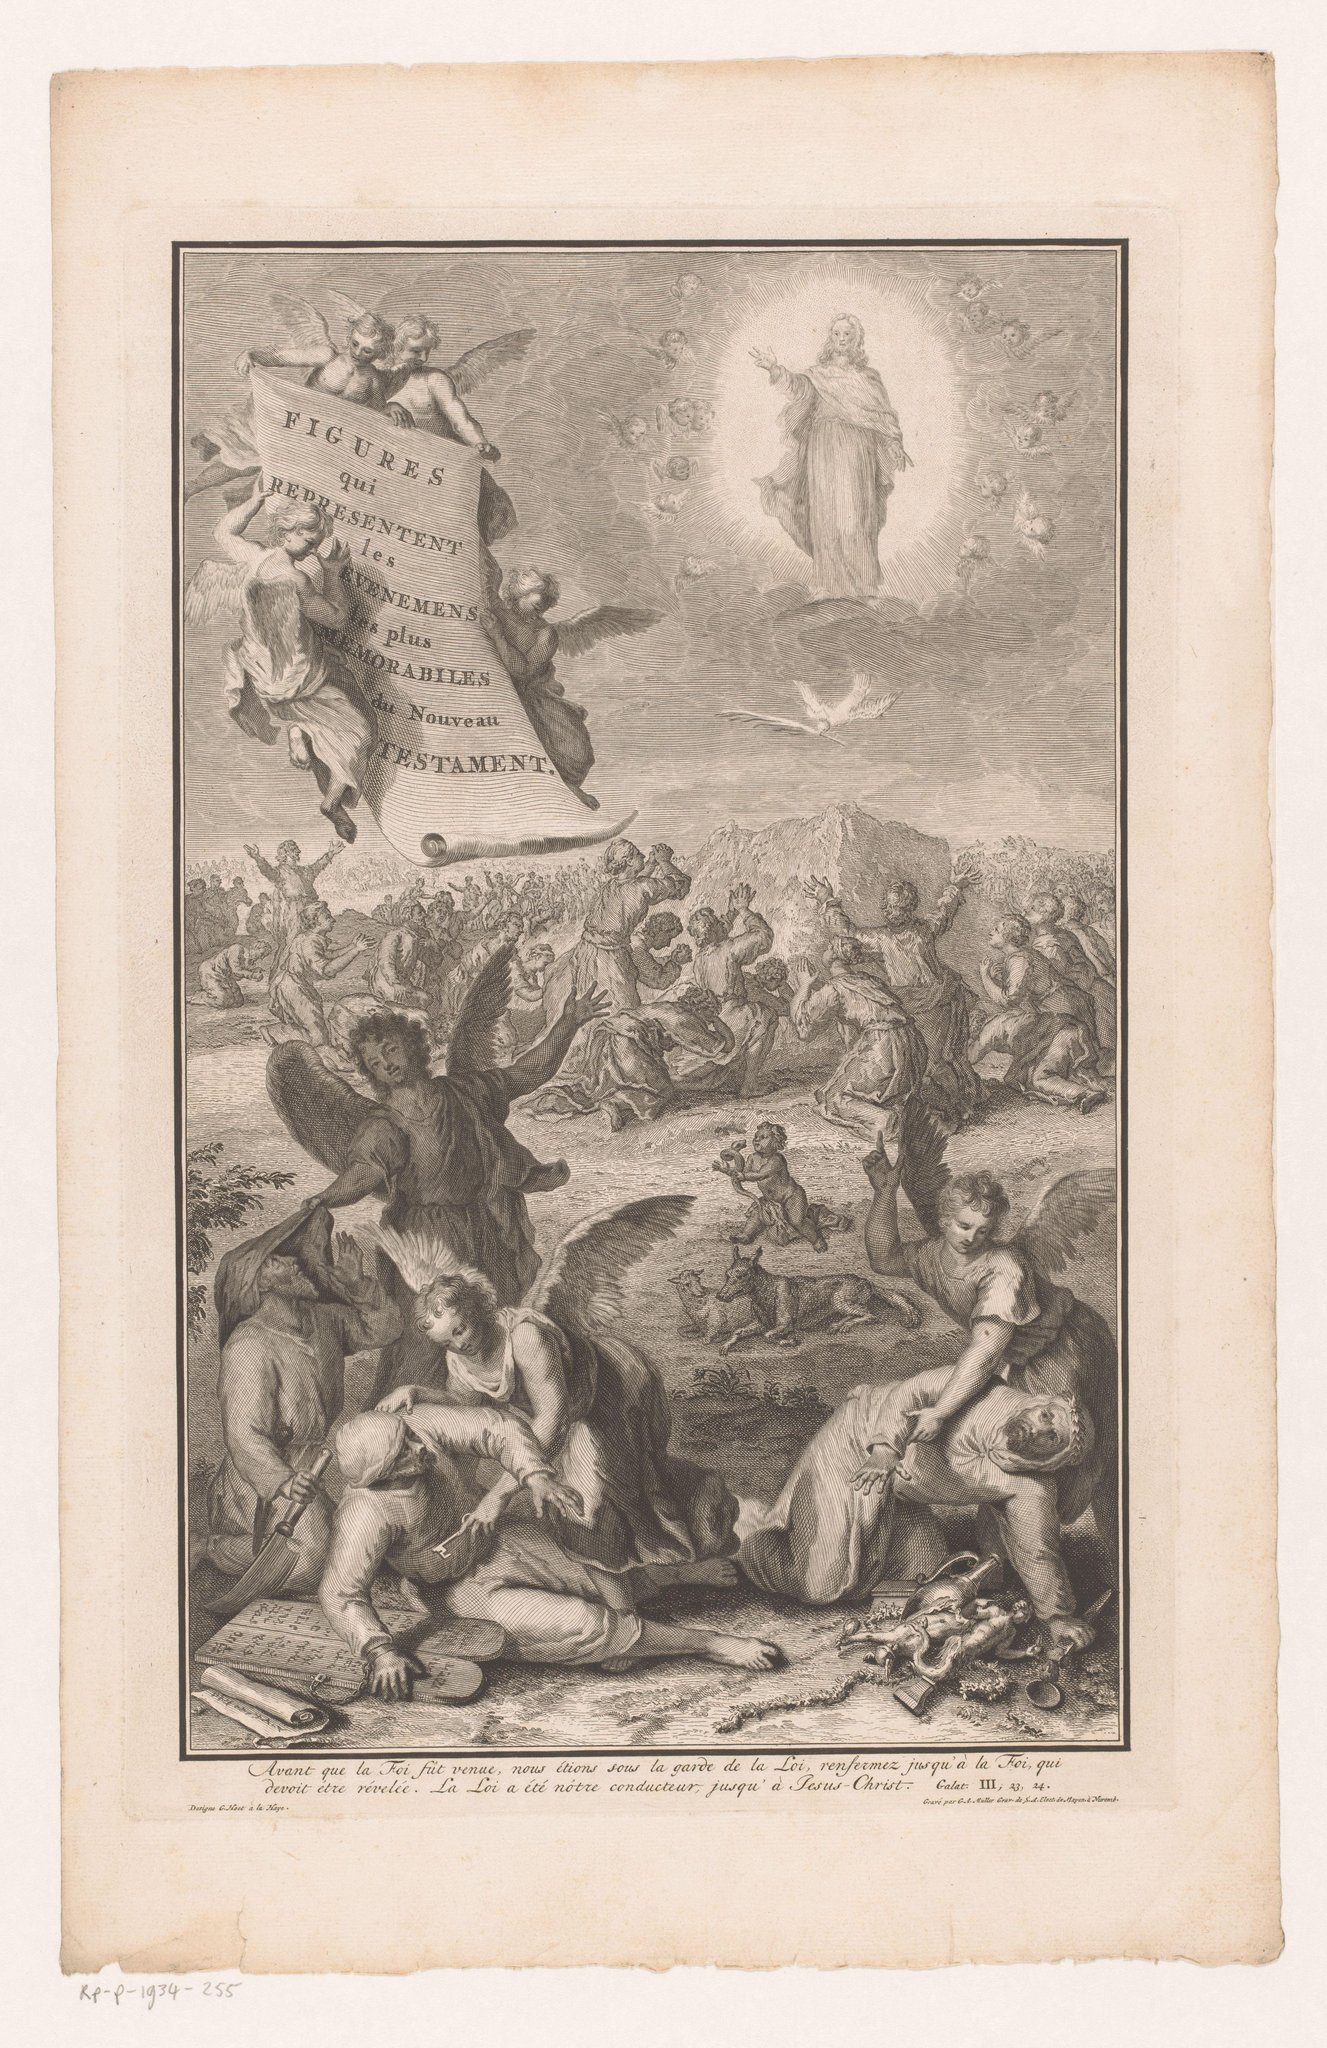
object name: print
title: Christus verschijnt aan de hemel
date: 1704-1767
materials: paper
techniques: engraving, etching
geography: nuremberg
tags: revelation 19-22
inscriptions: collector's mark: Lugt 2228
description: Christus verschijnt aan de hemel, mogelijk Apocalyps 19 (Johannes de Evangelist 14:14-20) "druiven der gramschap".